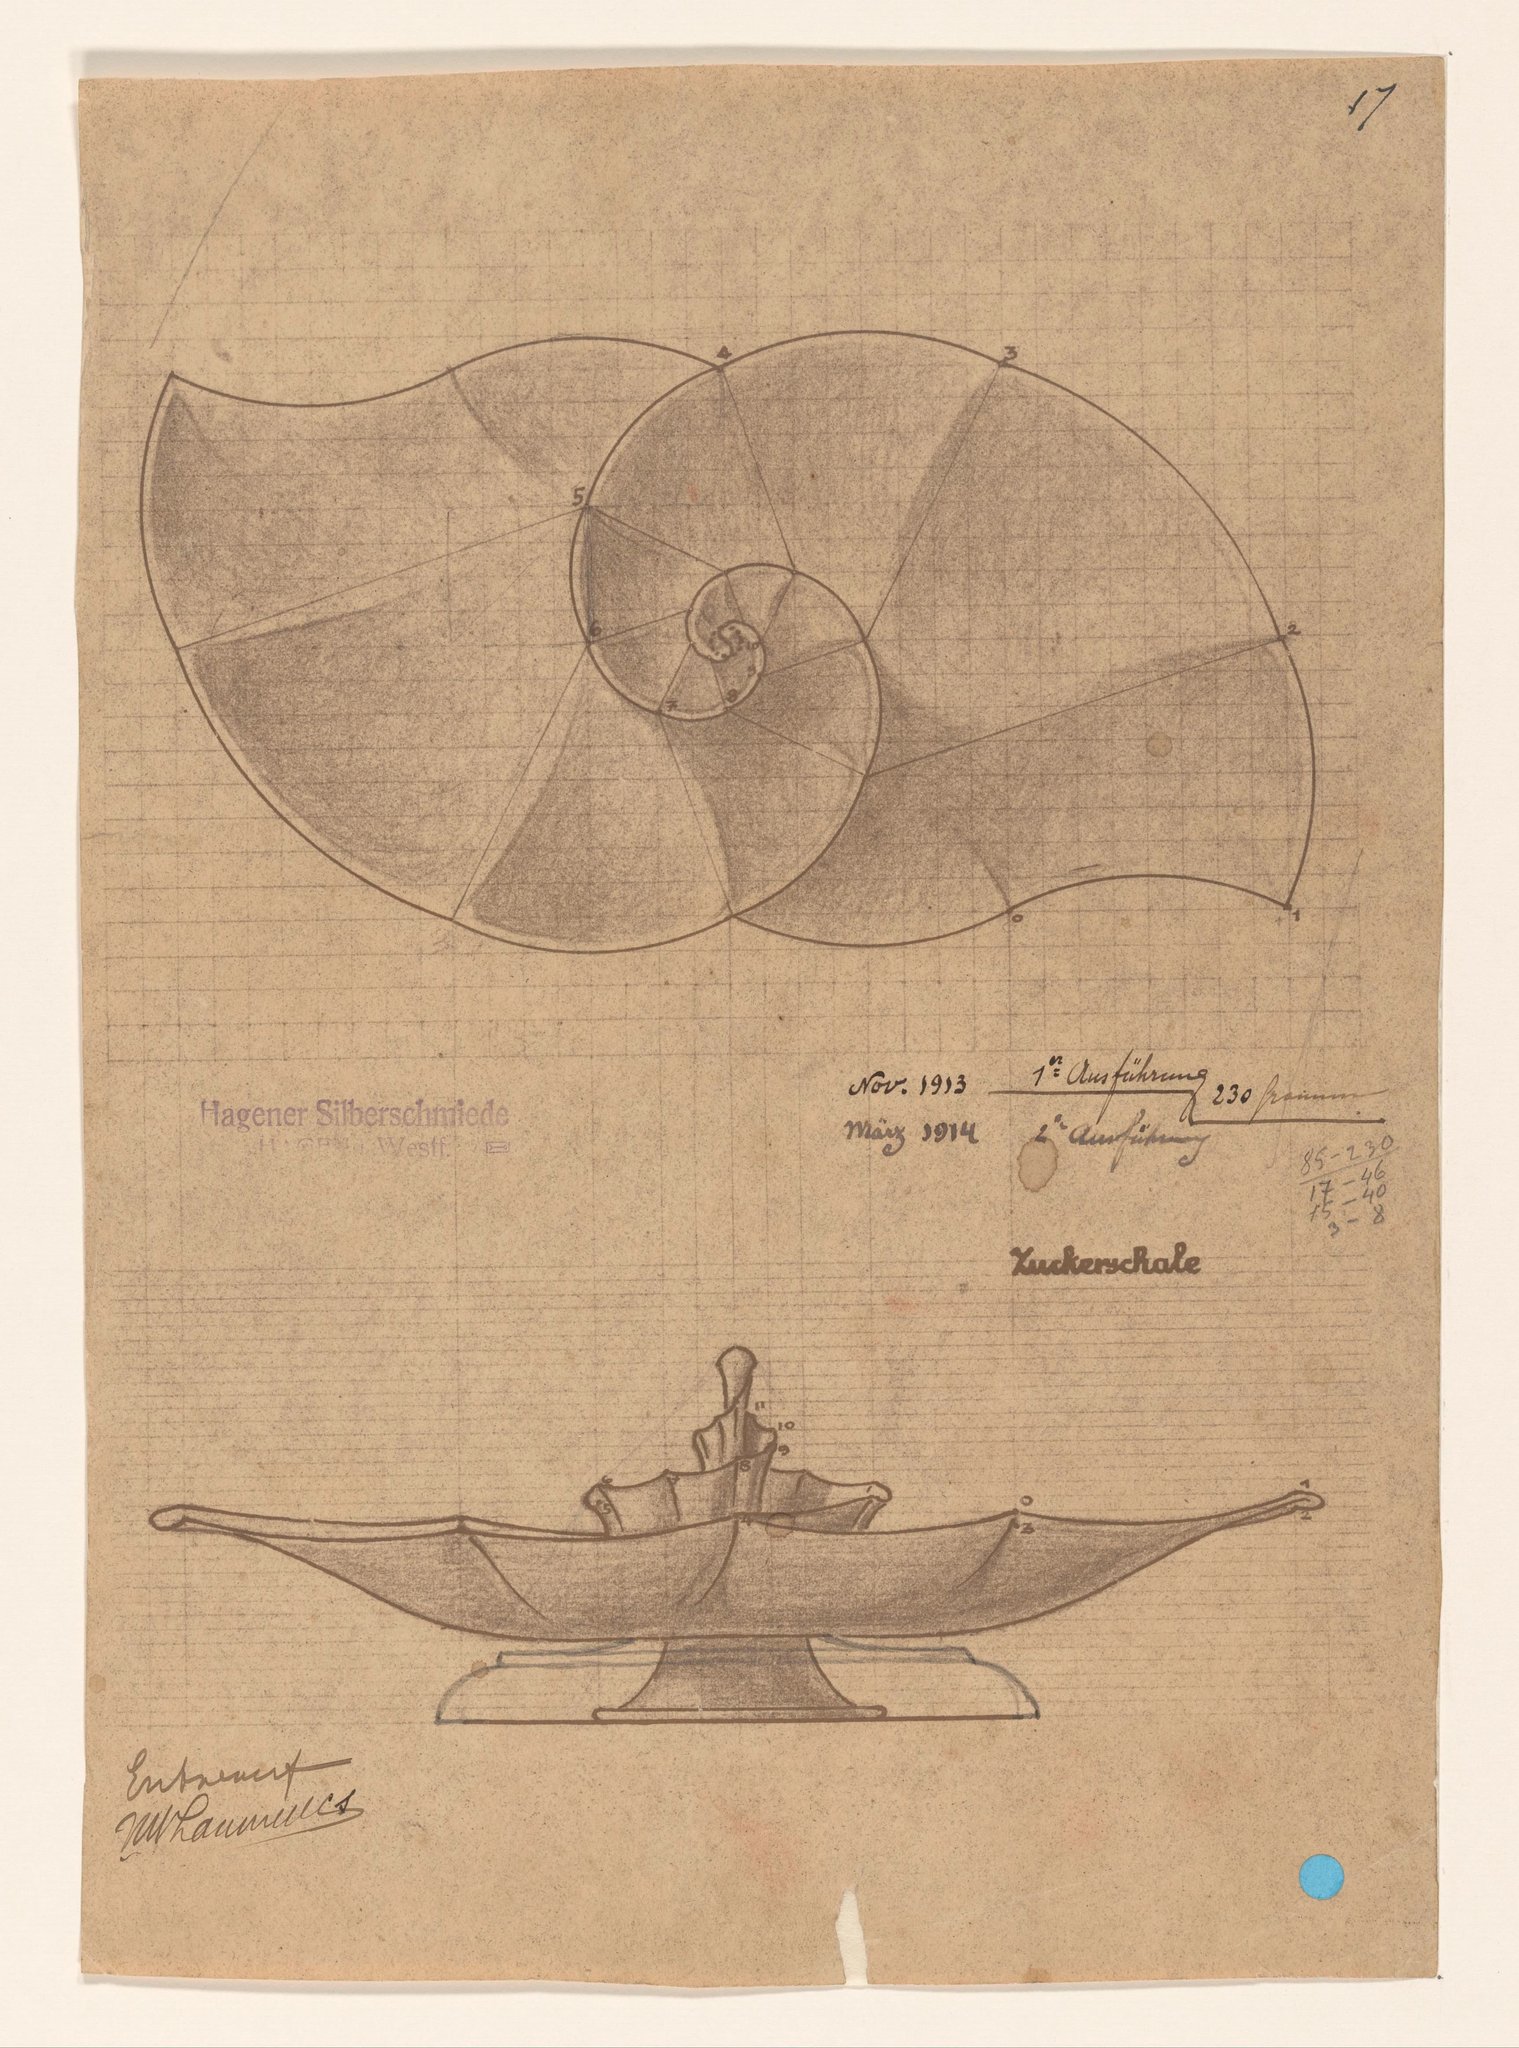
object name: design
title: Ontwerp voor een zilveren suikerschaal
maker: mathieu lauweriks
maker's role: designer, draughtsman, print maker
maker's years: 1864-1932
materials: ink, paper, pencil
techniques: pen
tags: sugar-basin, container of metal: bucket, can, canister, drum, tin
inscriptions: inscription: ‘Zuckerschale’